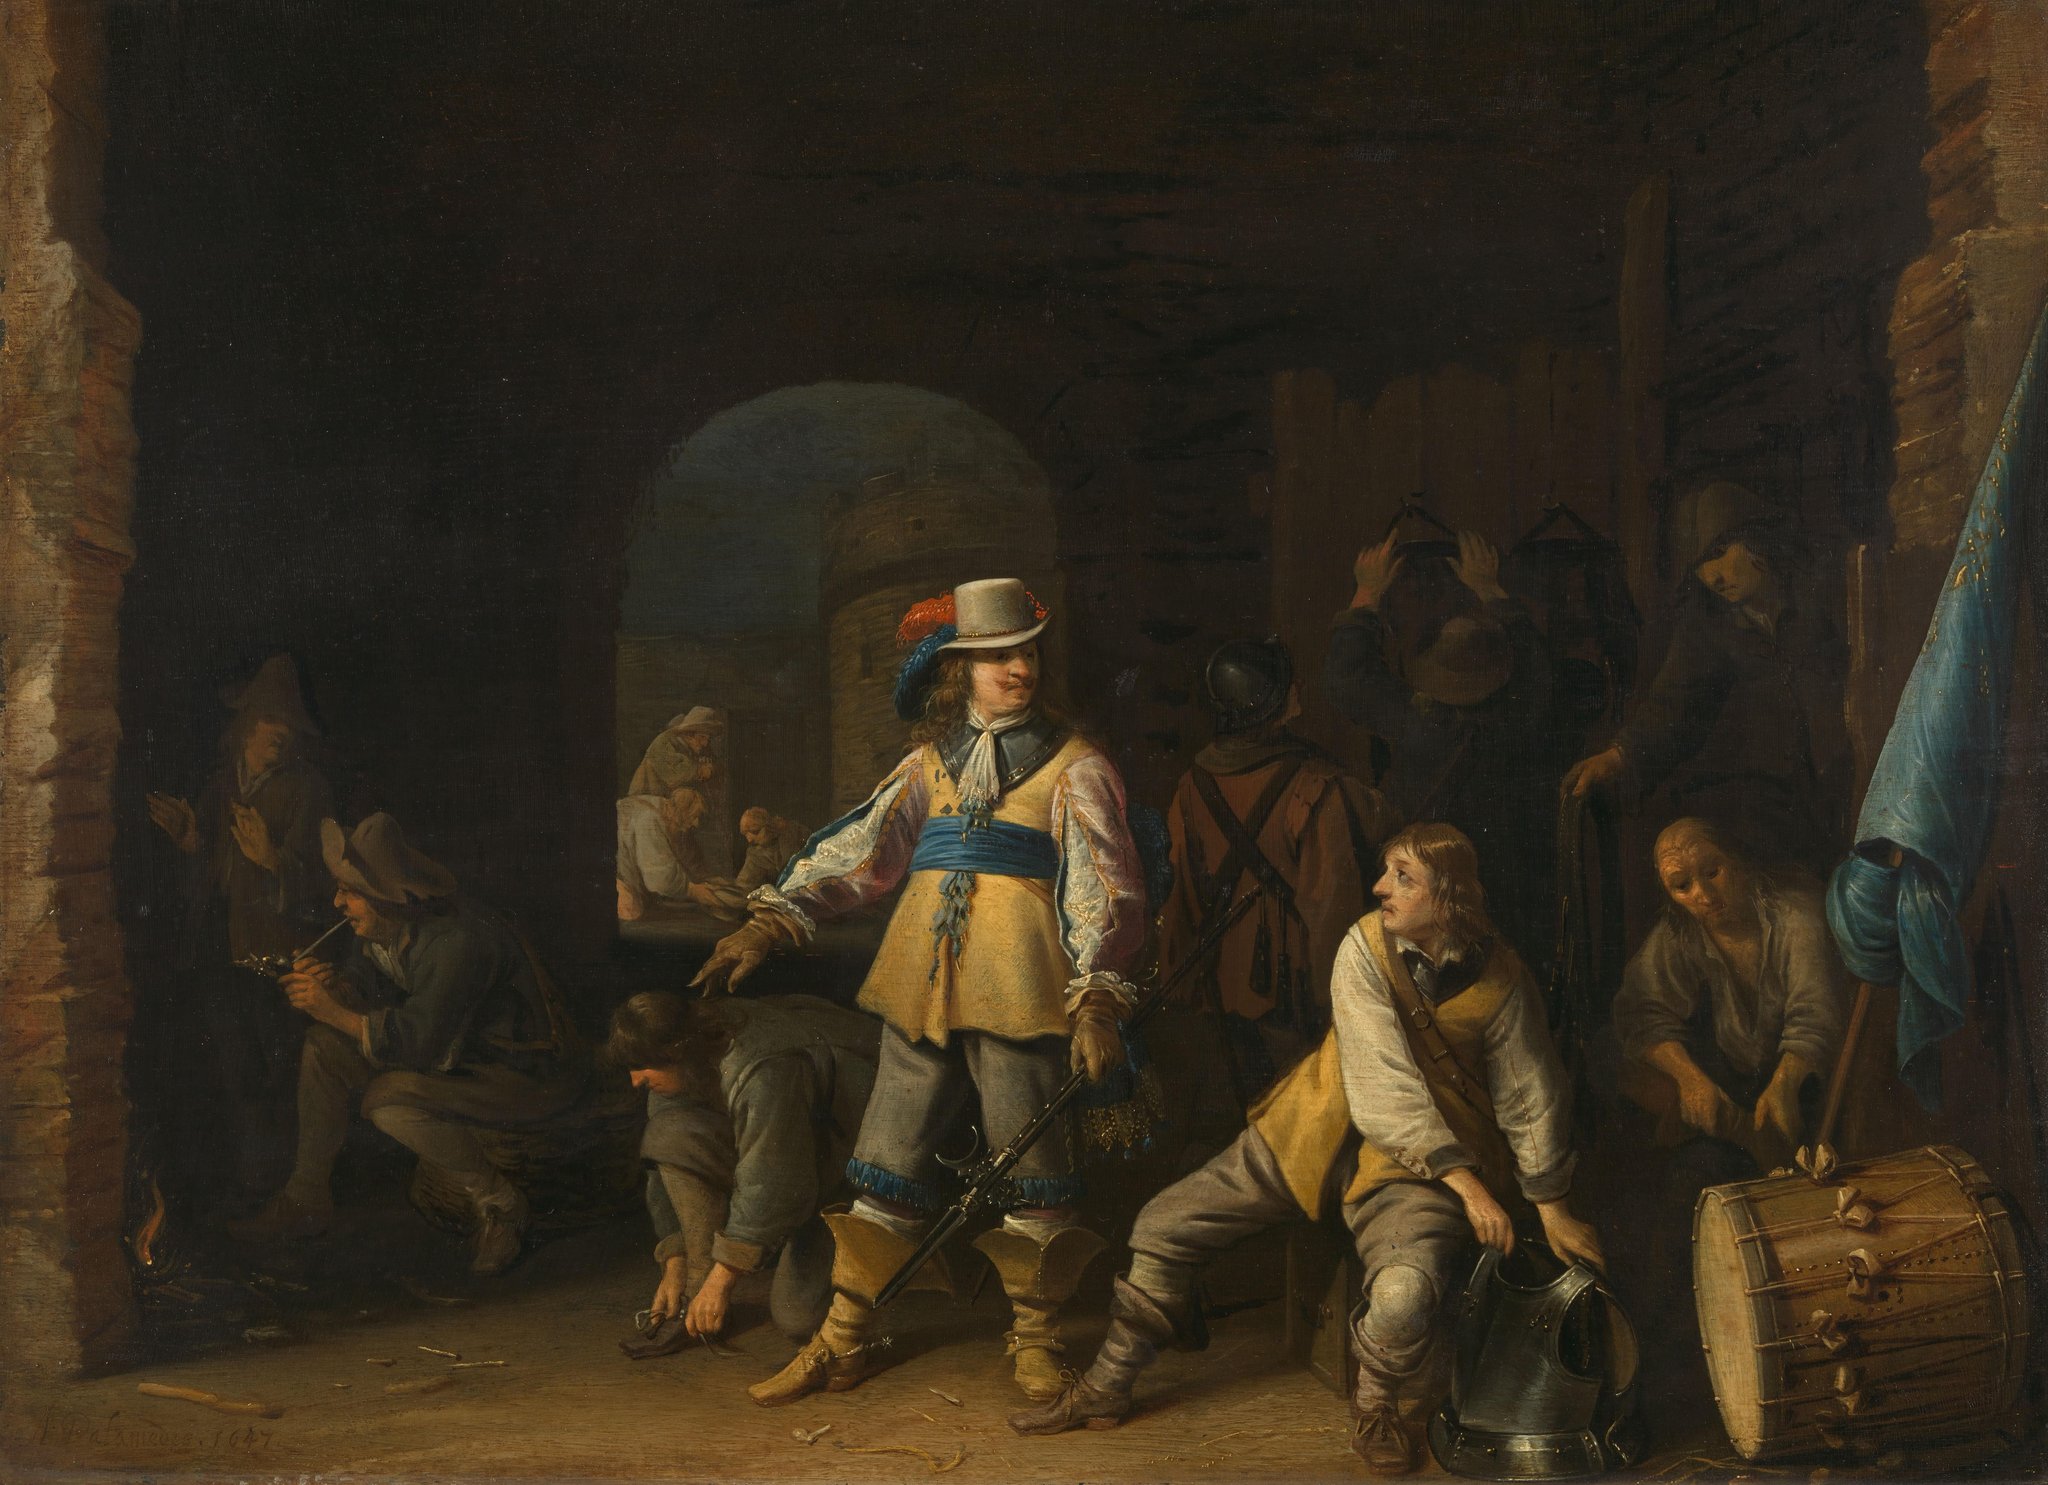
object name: painting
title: Soldiers in a Guardroom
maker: anthonie palamedesz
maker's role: draughtsman, painter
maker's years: 1601-1673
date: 1647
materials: oil, panel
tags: in the guard-room, 'kortegaard'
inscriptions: signature and date, bottom left: ‘A. Palamedes. 1647’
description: Kortegaard: wachtlokaal met soldaten. Staande tussen zijn manschappen deelt een officier bevelen uit. Rechts een soldaat met een vaandel en trom, daarnaast een man met een borstharnas. Links warmen twee mannen zich bij de haard.